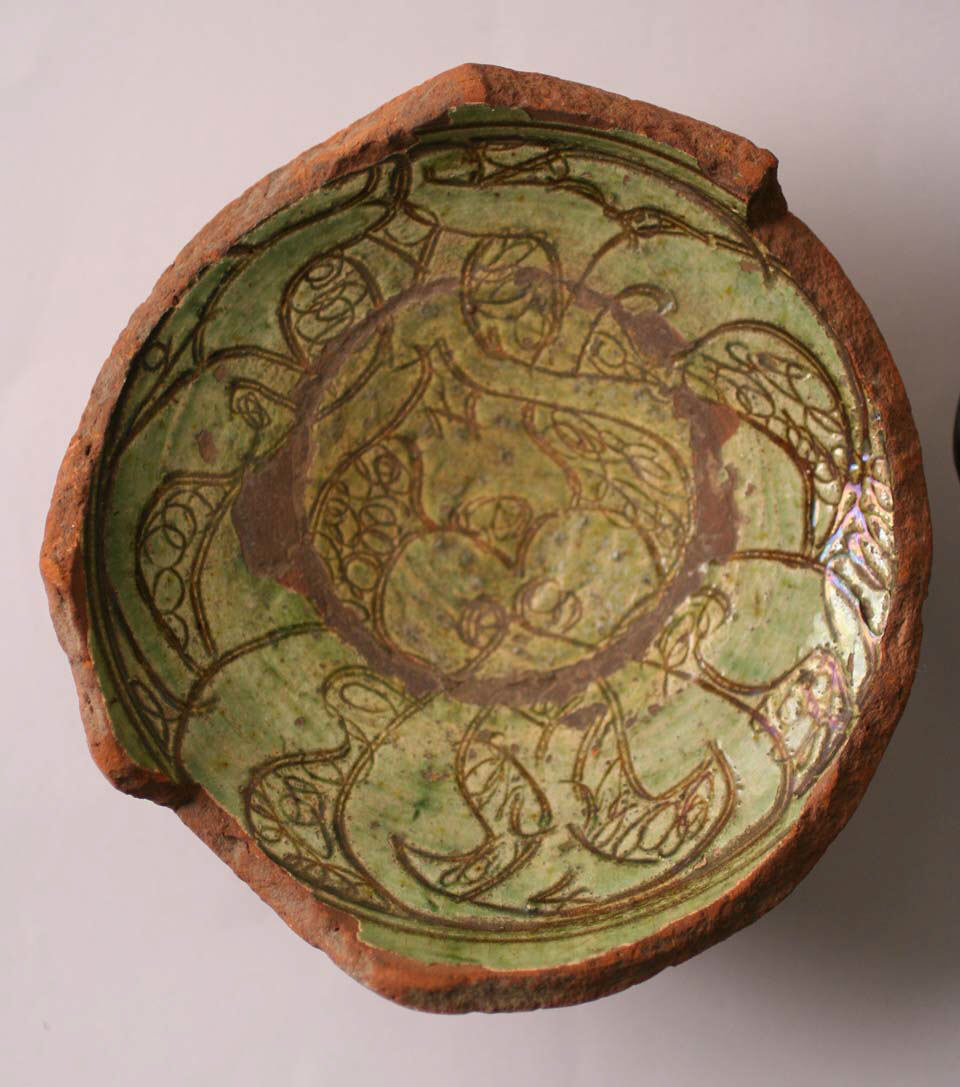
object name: fragment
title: Fragment of a Bowl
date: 1301-1500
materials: earthenware, glaze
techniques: coloring, incising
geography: egypt